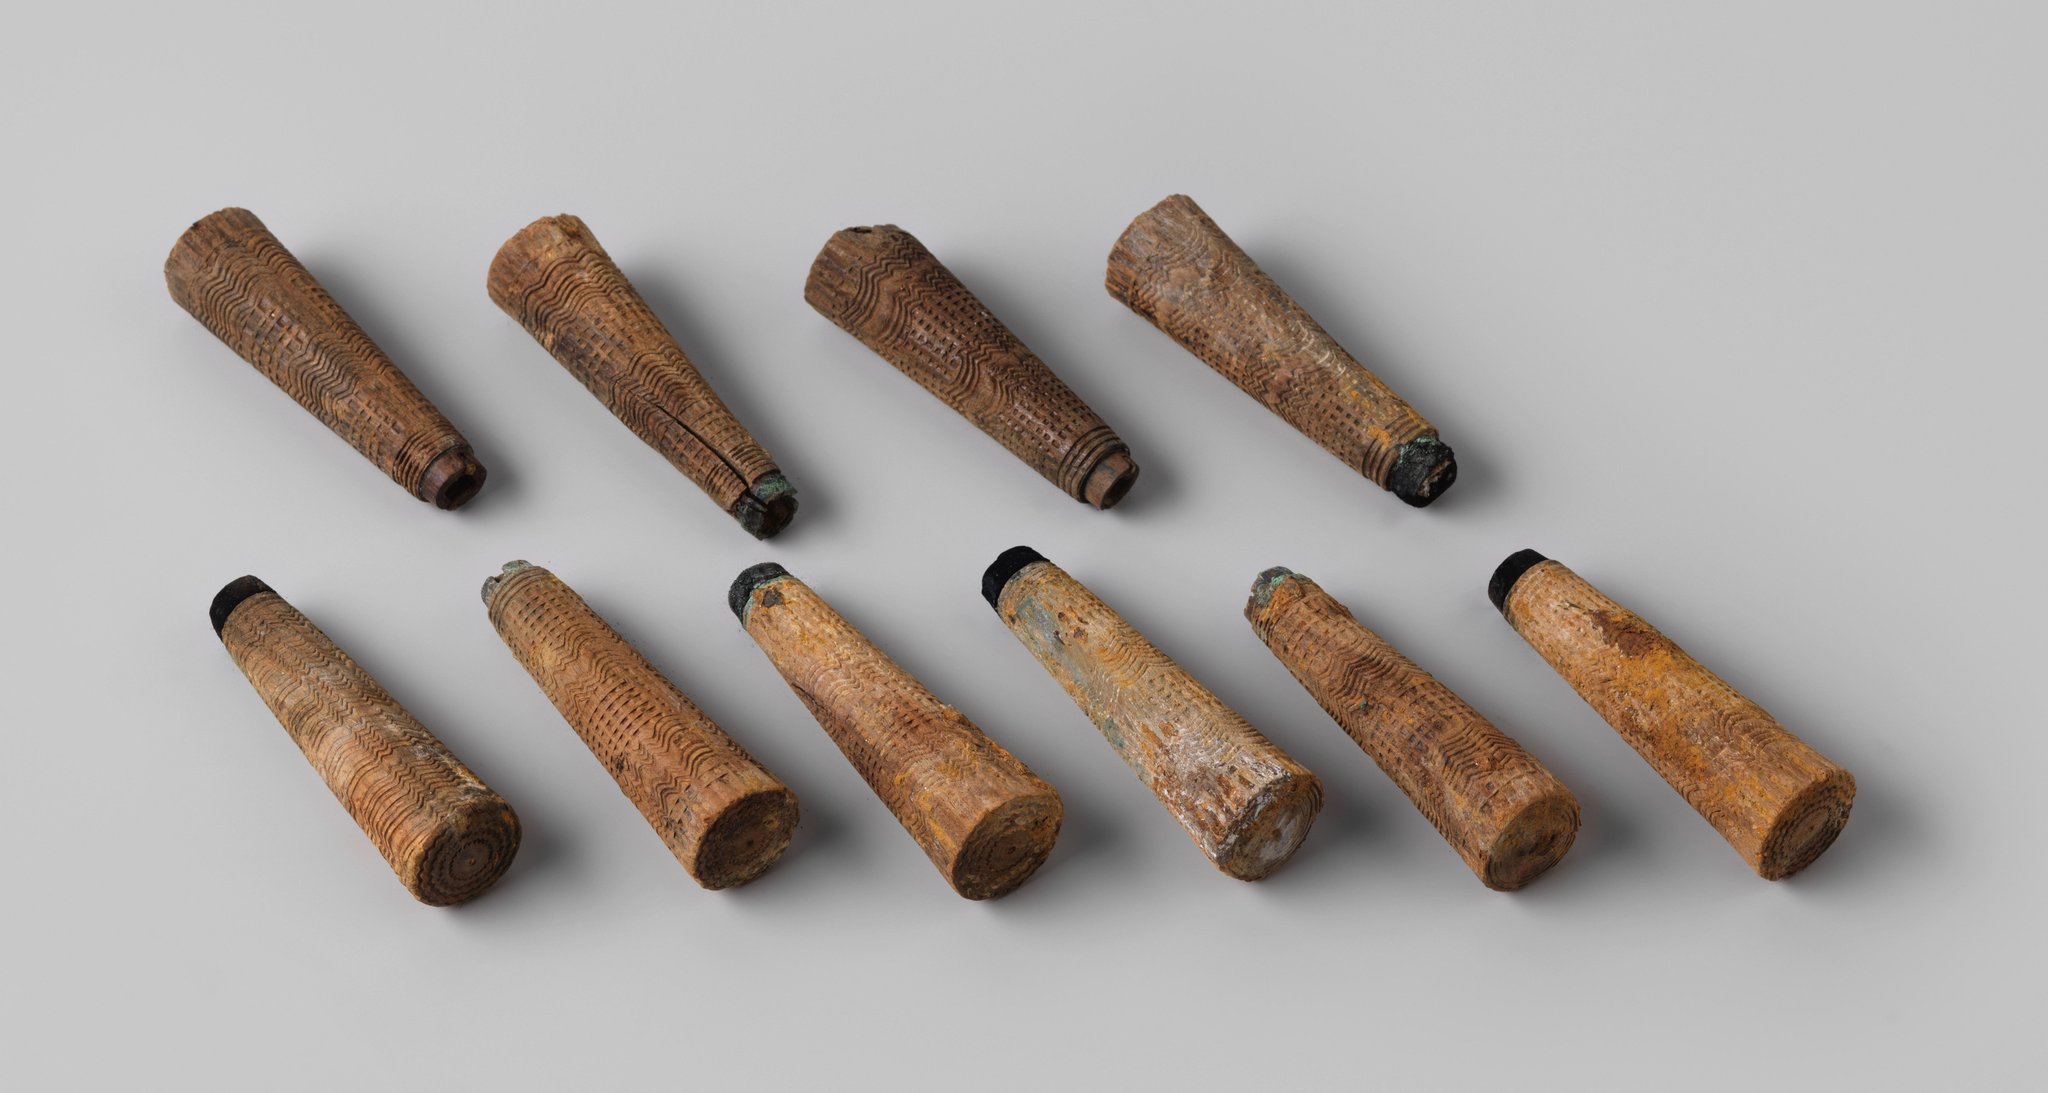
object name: knife handle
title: Messenheften en losse koperring uit het wrak van de Oost-Indiëvaarder Hollandia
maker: Anonymous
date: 1700-1743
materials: copper, wood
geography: netherlands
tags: verenigde oostindische compagnie, hollandia (schip), annet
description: Knife, handle, cylindrical: tapering; id. NG 1979-403H, ferrules, id. NG 1980-27H426.